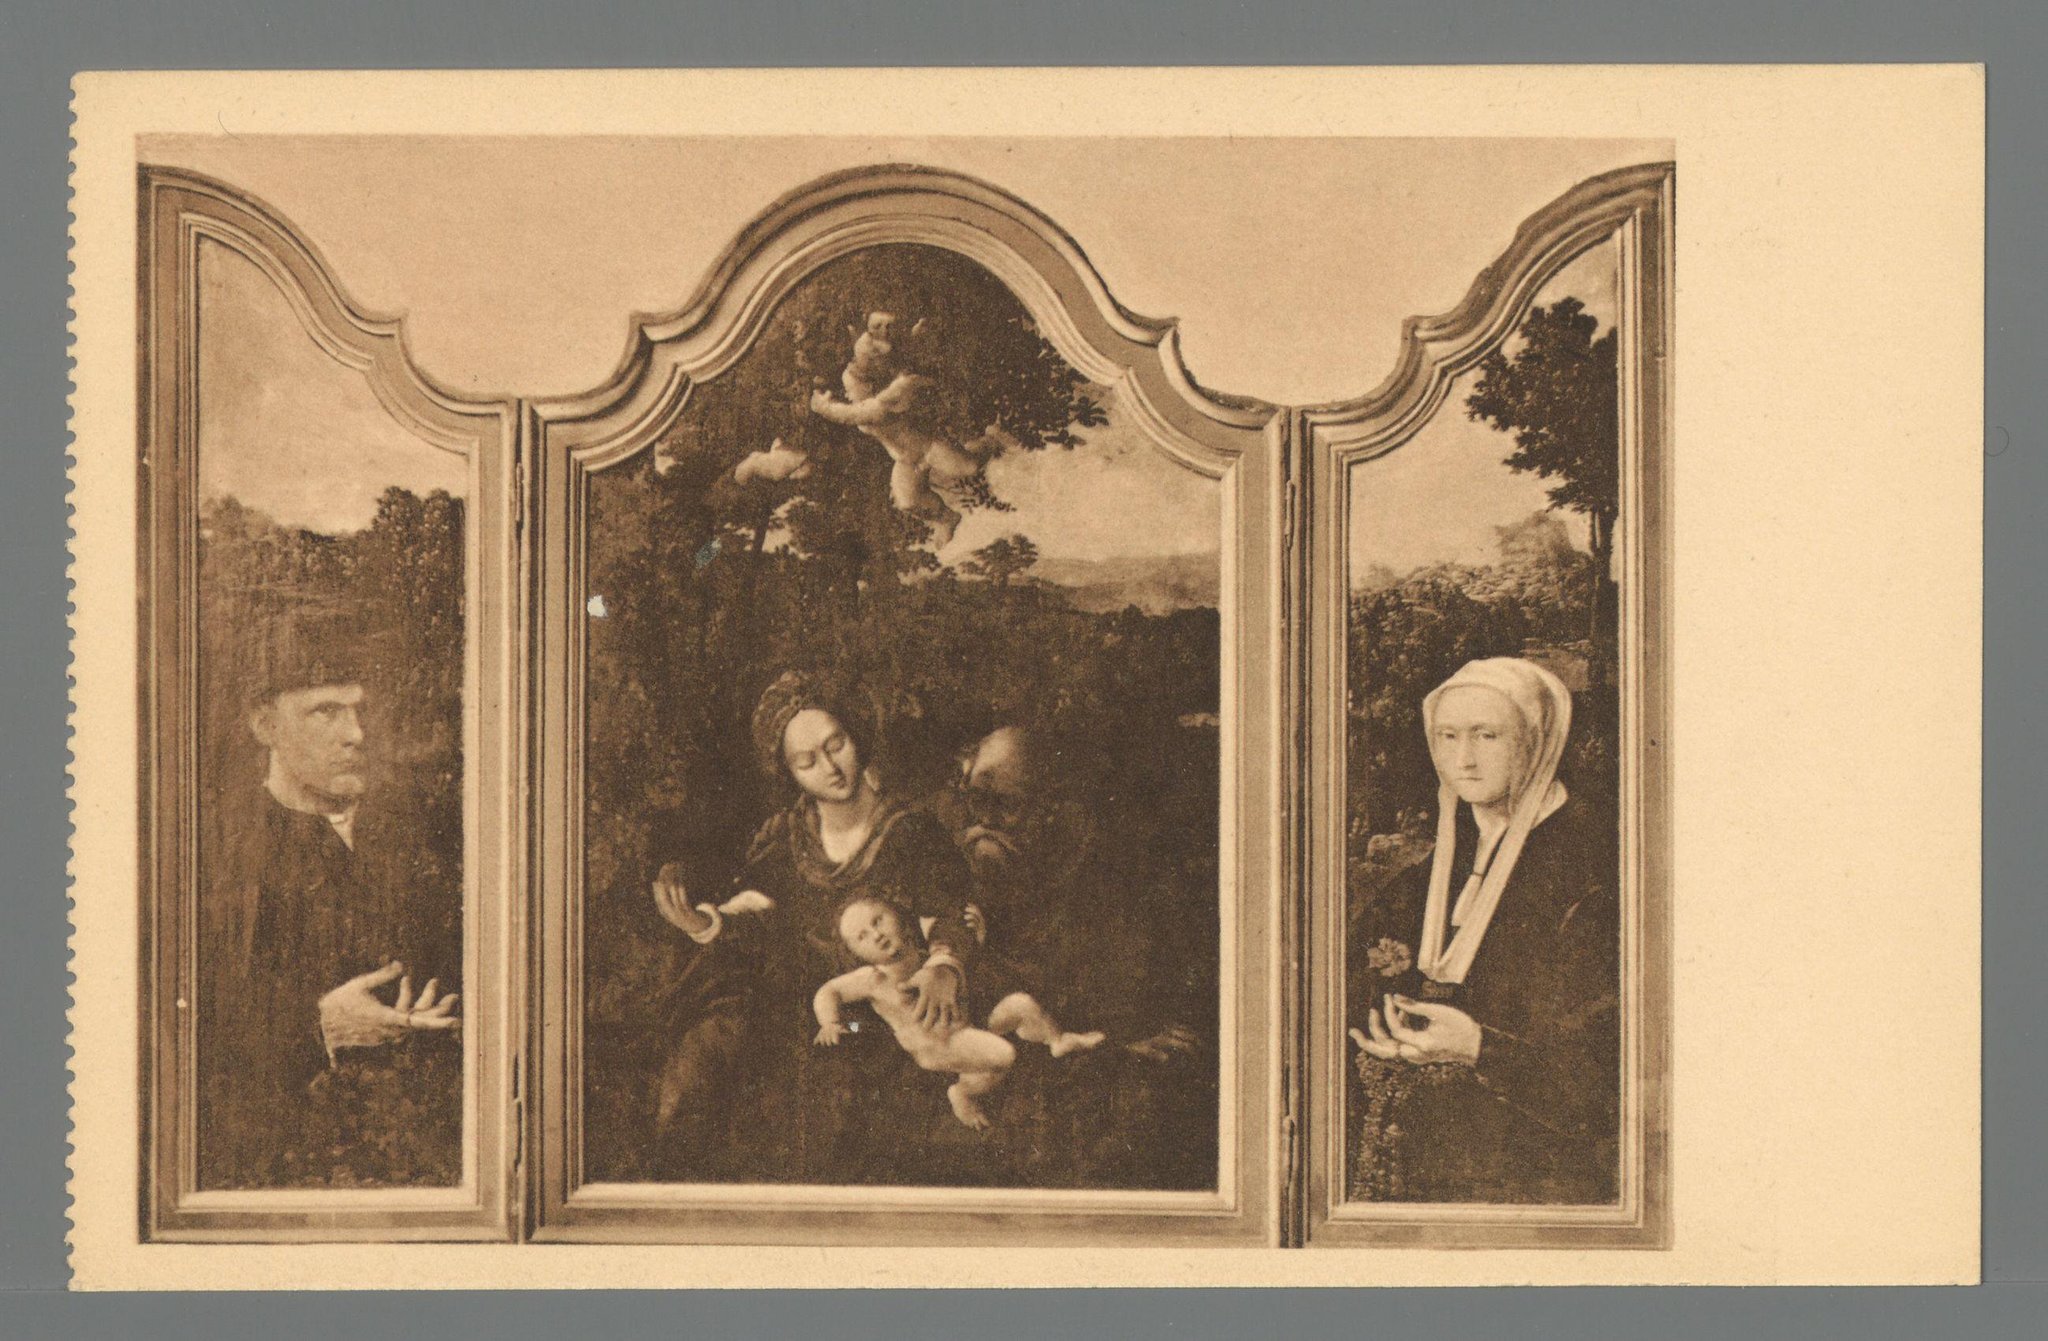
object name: photomechanical print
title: Aartsb. Museum, Utrecht. Triptiek. De H. familie (met don.). Copie naar een It. meester. XVIde eeuw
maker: Anonymous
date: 1908-1921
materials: cardboard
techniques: photograph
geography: rotterdam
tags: permanent exhibition, museum, picture, painting